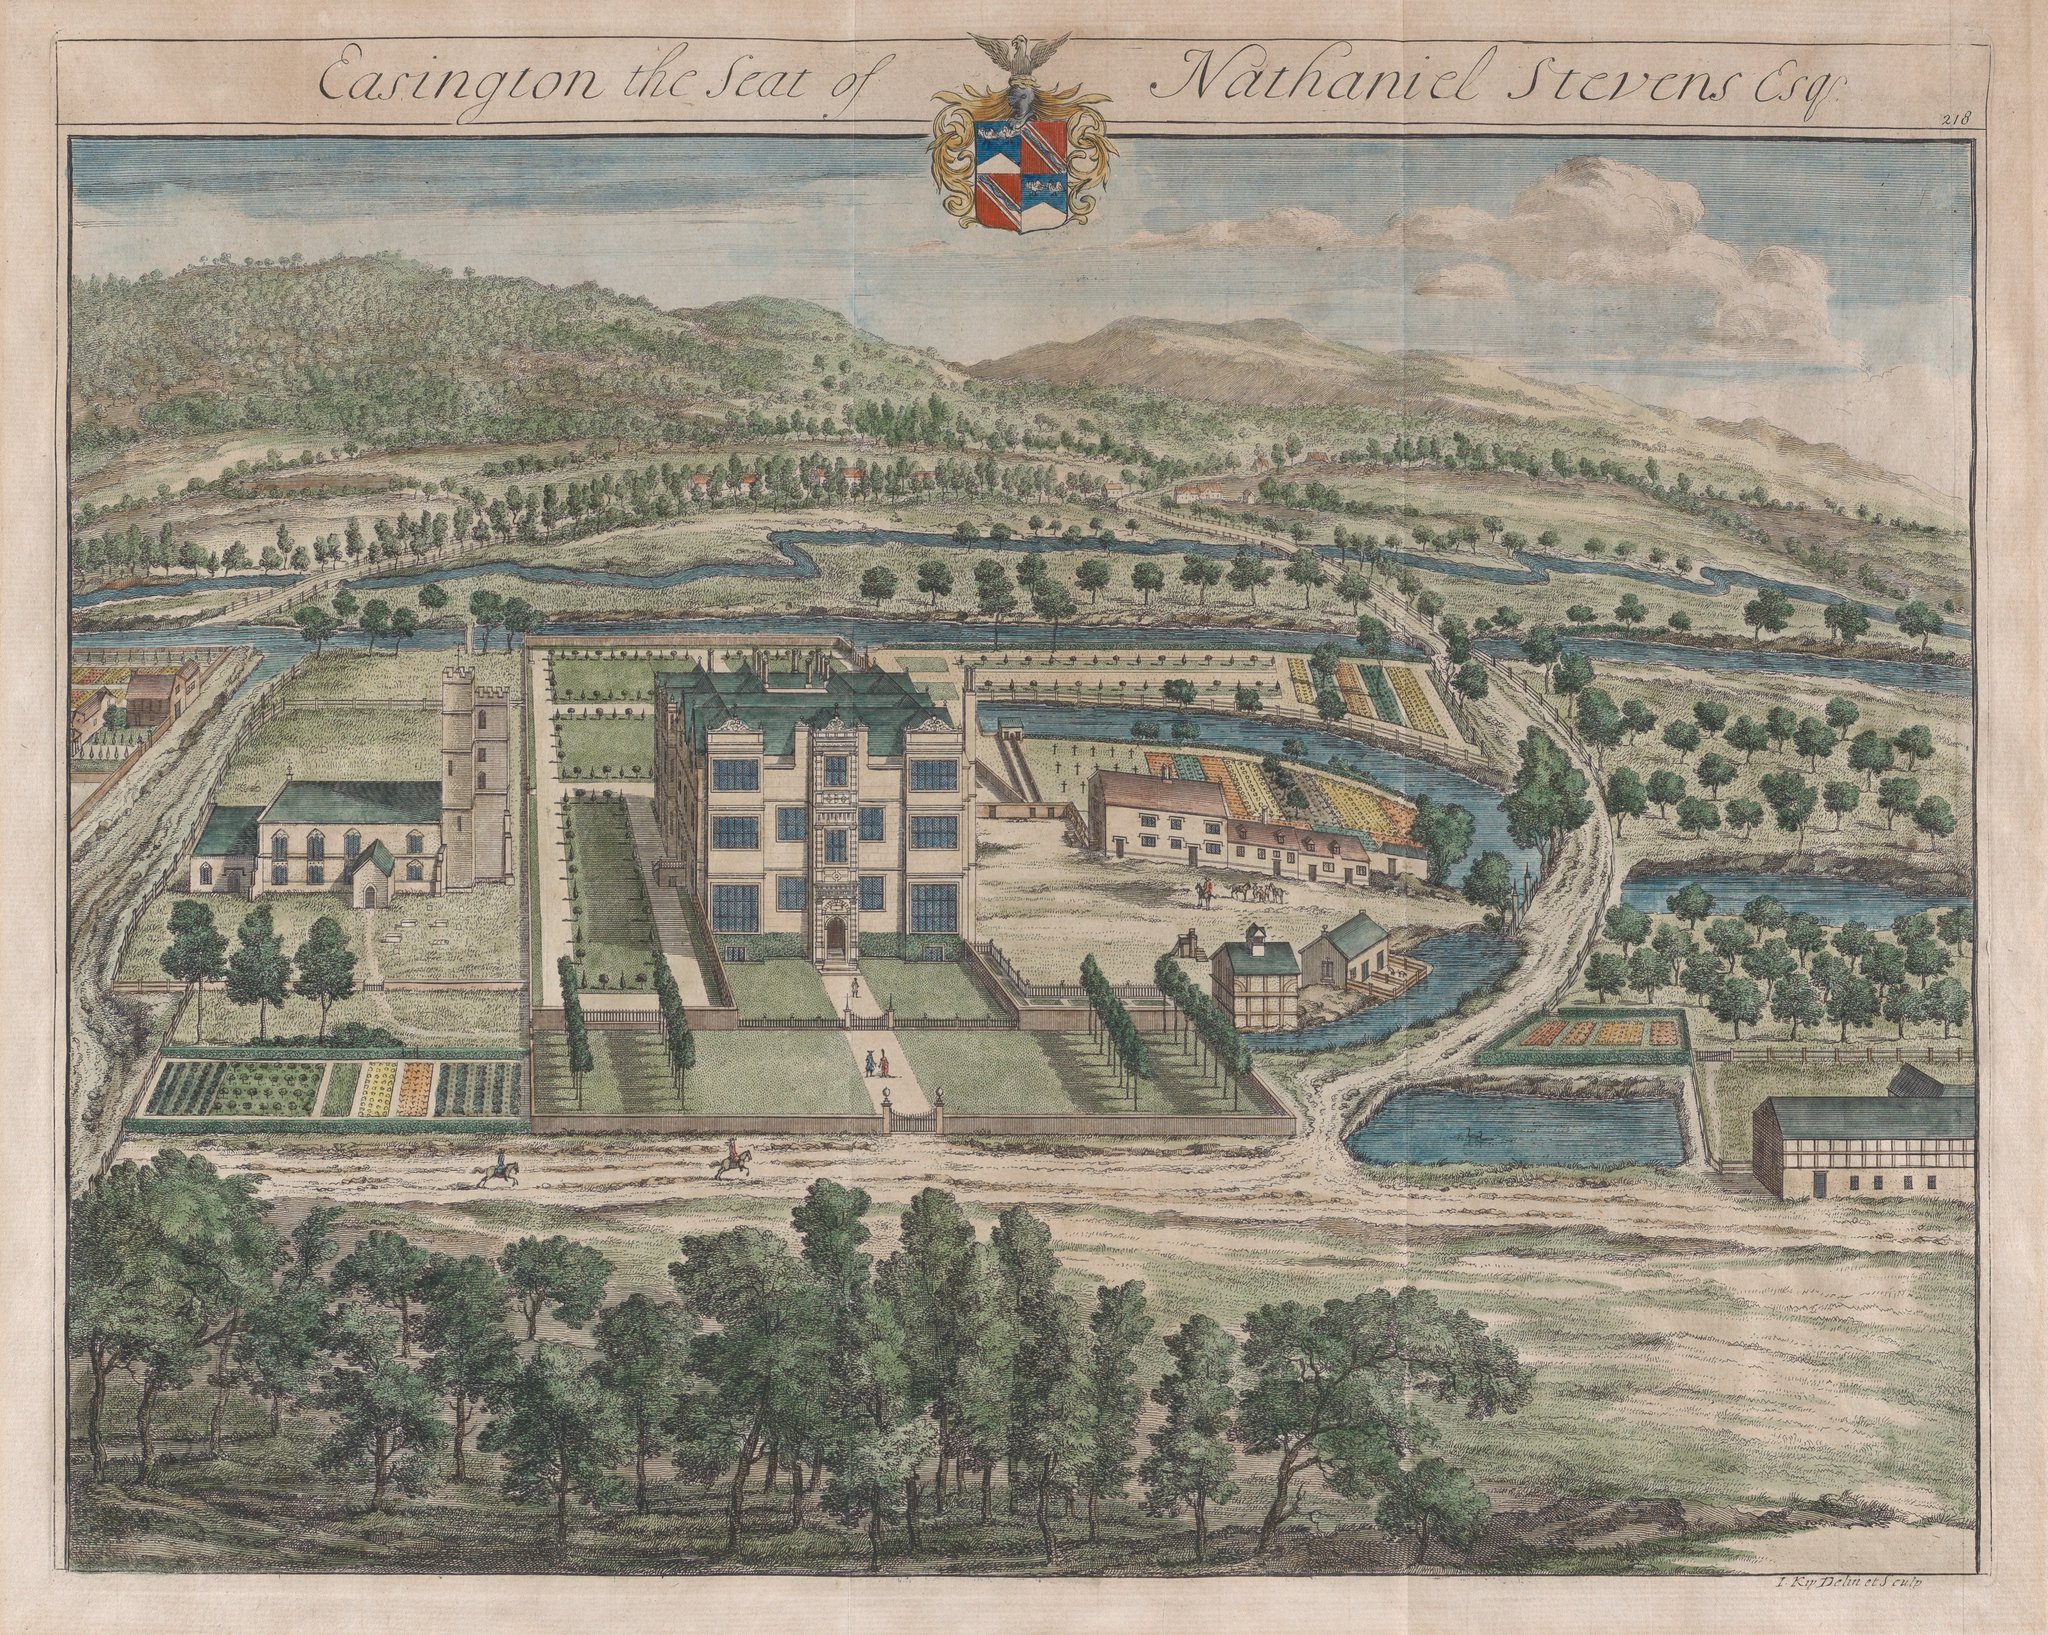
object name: print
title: Easington, The Seat of Nathaniel Stevens, plate 218 from "The Ancient and Present State of Gloucestershire"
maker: johannes kip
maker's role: artist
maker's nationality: dutch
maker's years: 1653-1722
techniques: engraving, etching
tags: houses,gardens,landscapes,coat of arms